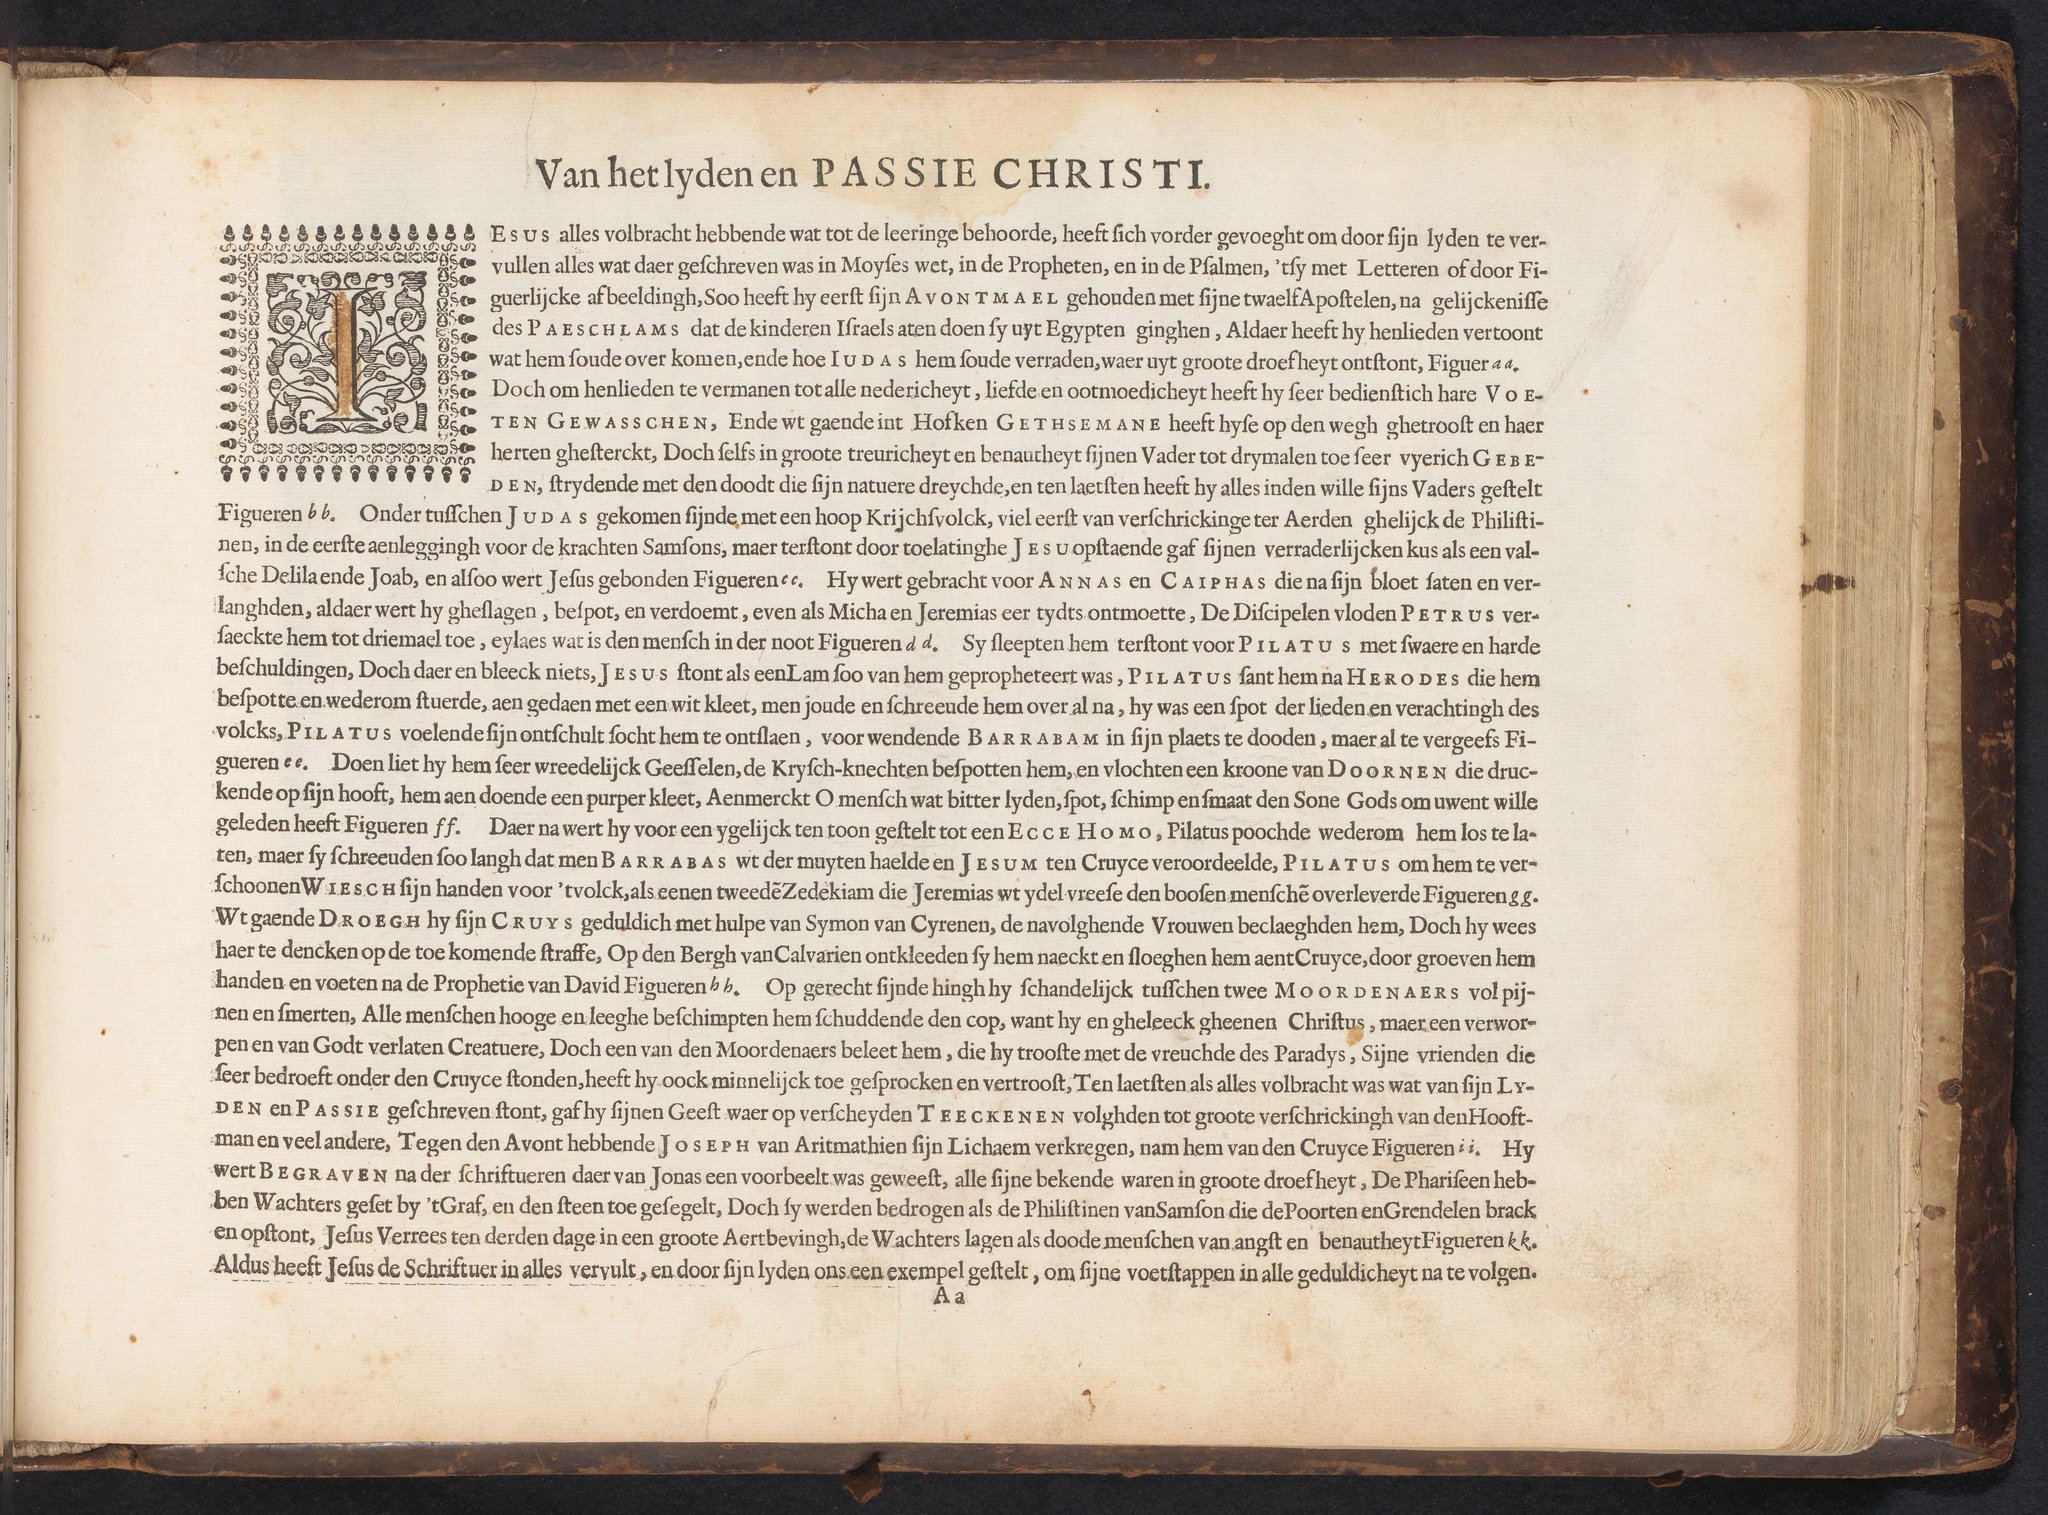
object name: text sheet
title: Van het lyden en Passie Christi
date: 1646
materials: paper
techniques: hand coloring, letterpress printing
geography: alkmaar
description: Tekstblad bij een serie prenten over de passie van Christus. Linksboven initiaal I. Dit blad maakt deel uit van een album.